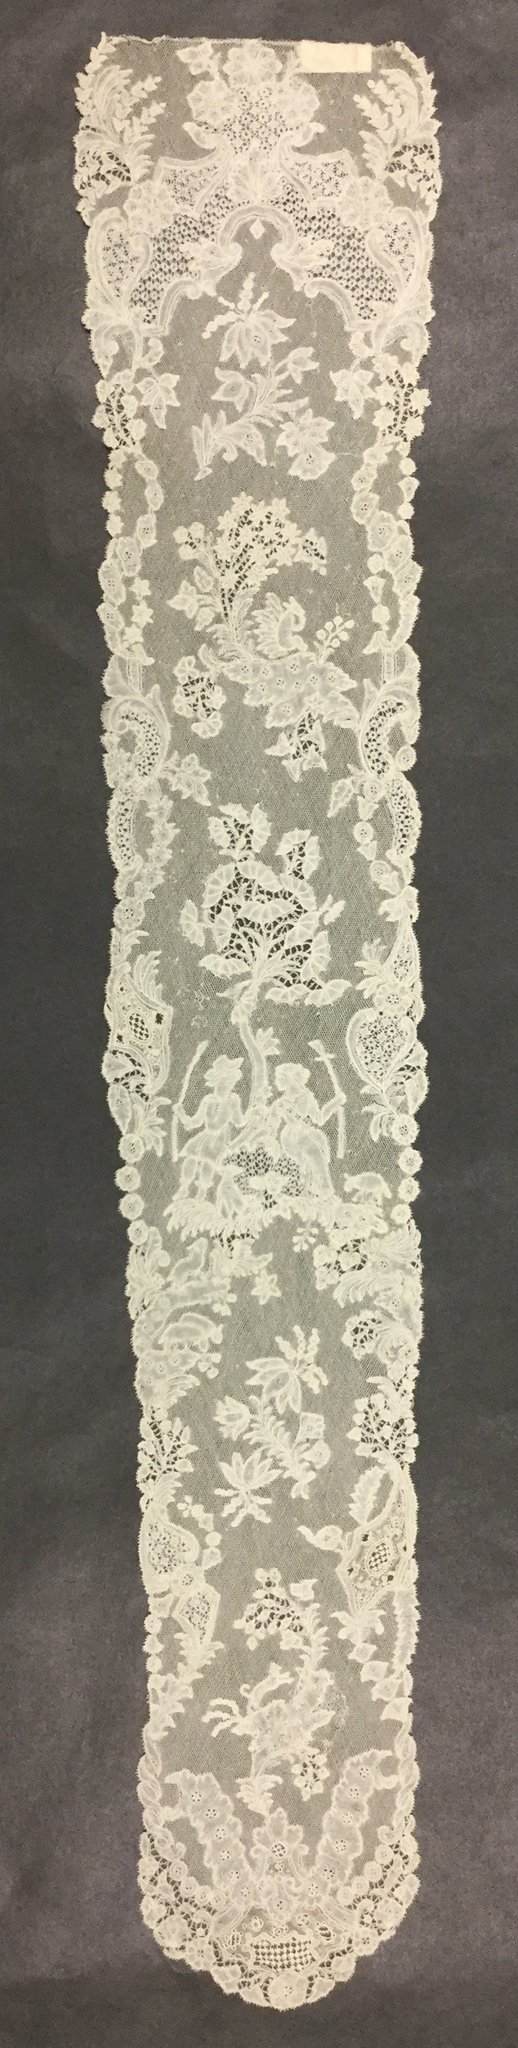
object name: lappet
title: Lappet (one of a pair)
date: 1734-1766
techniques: lace